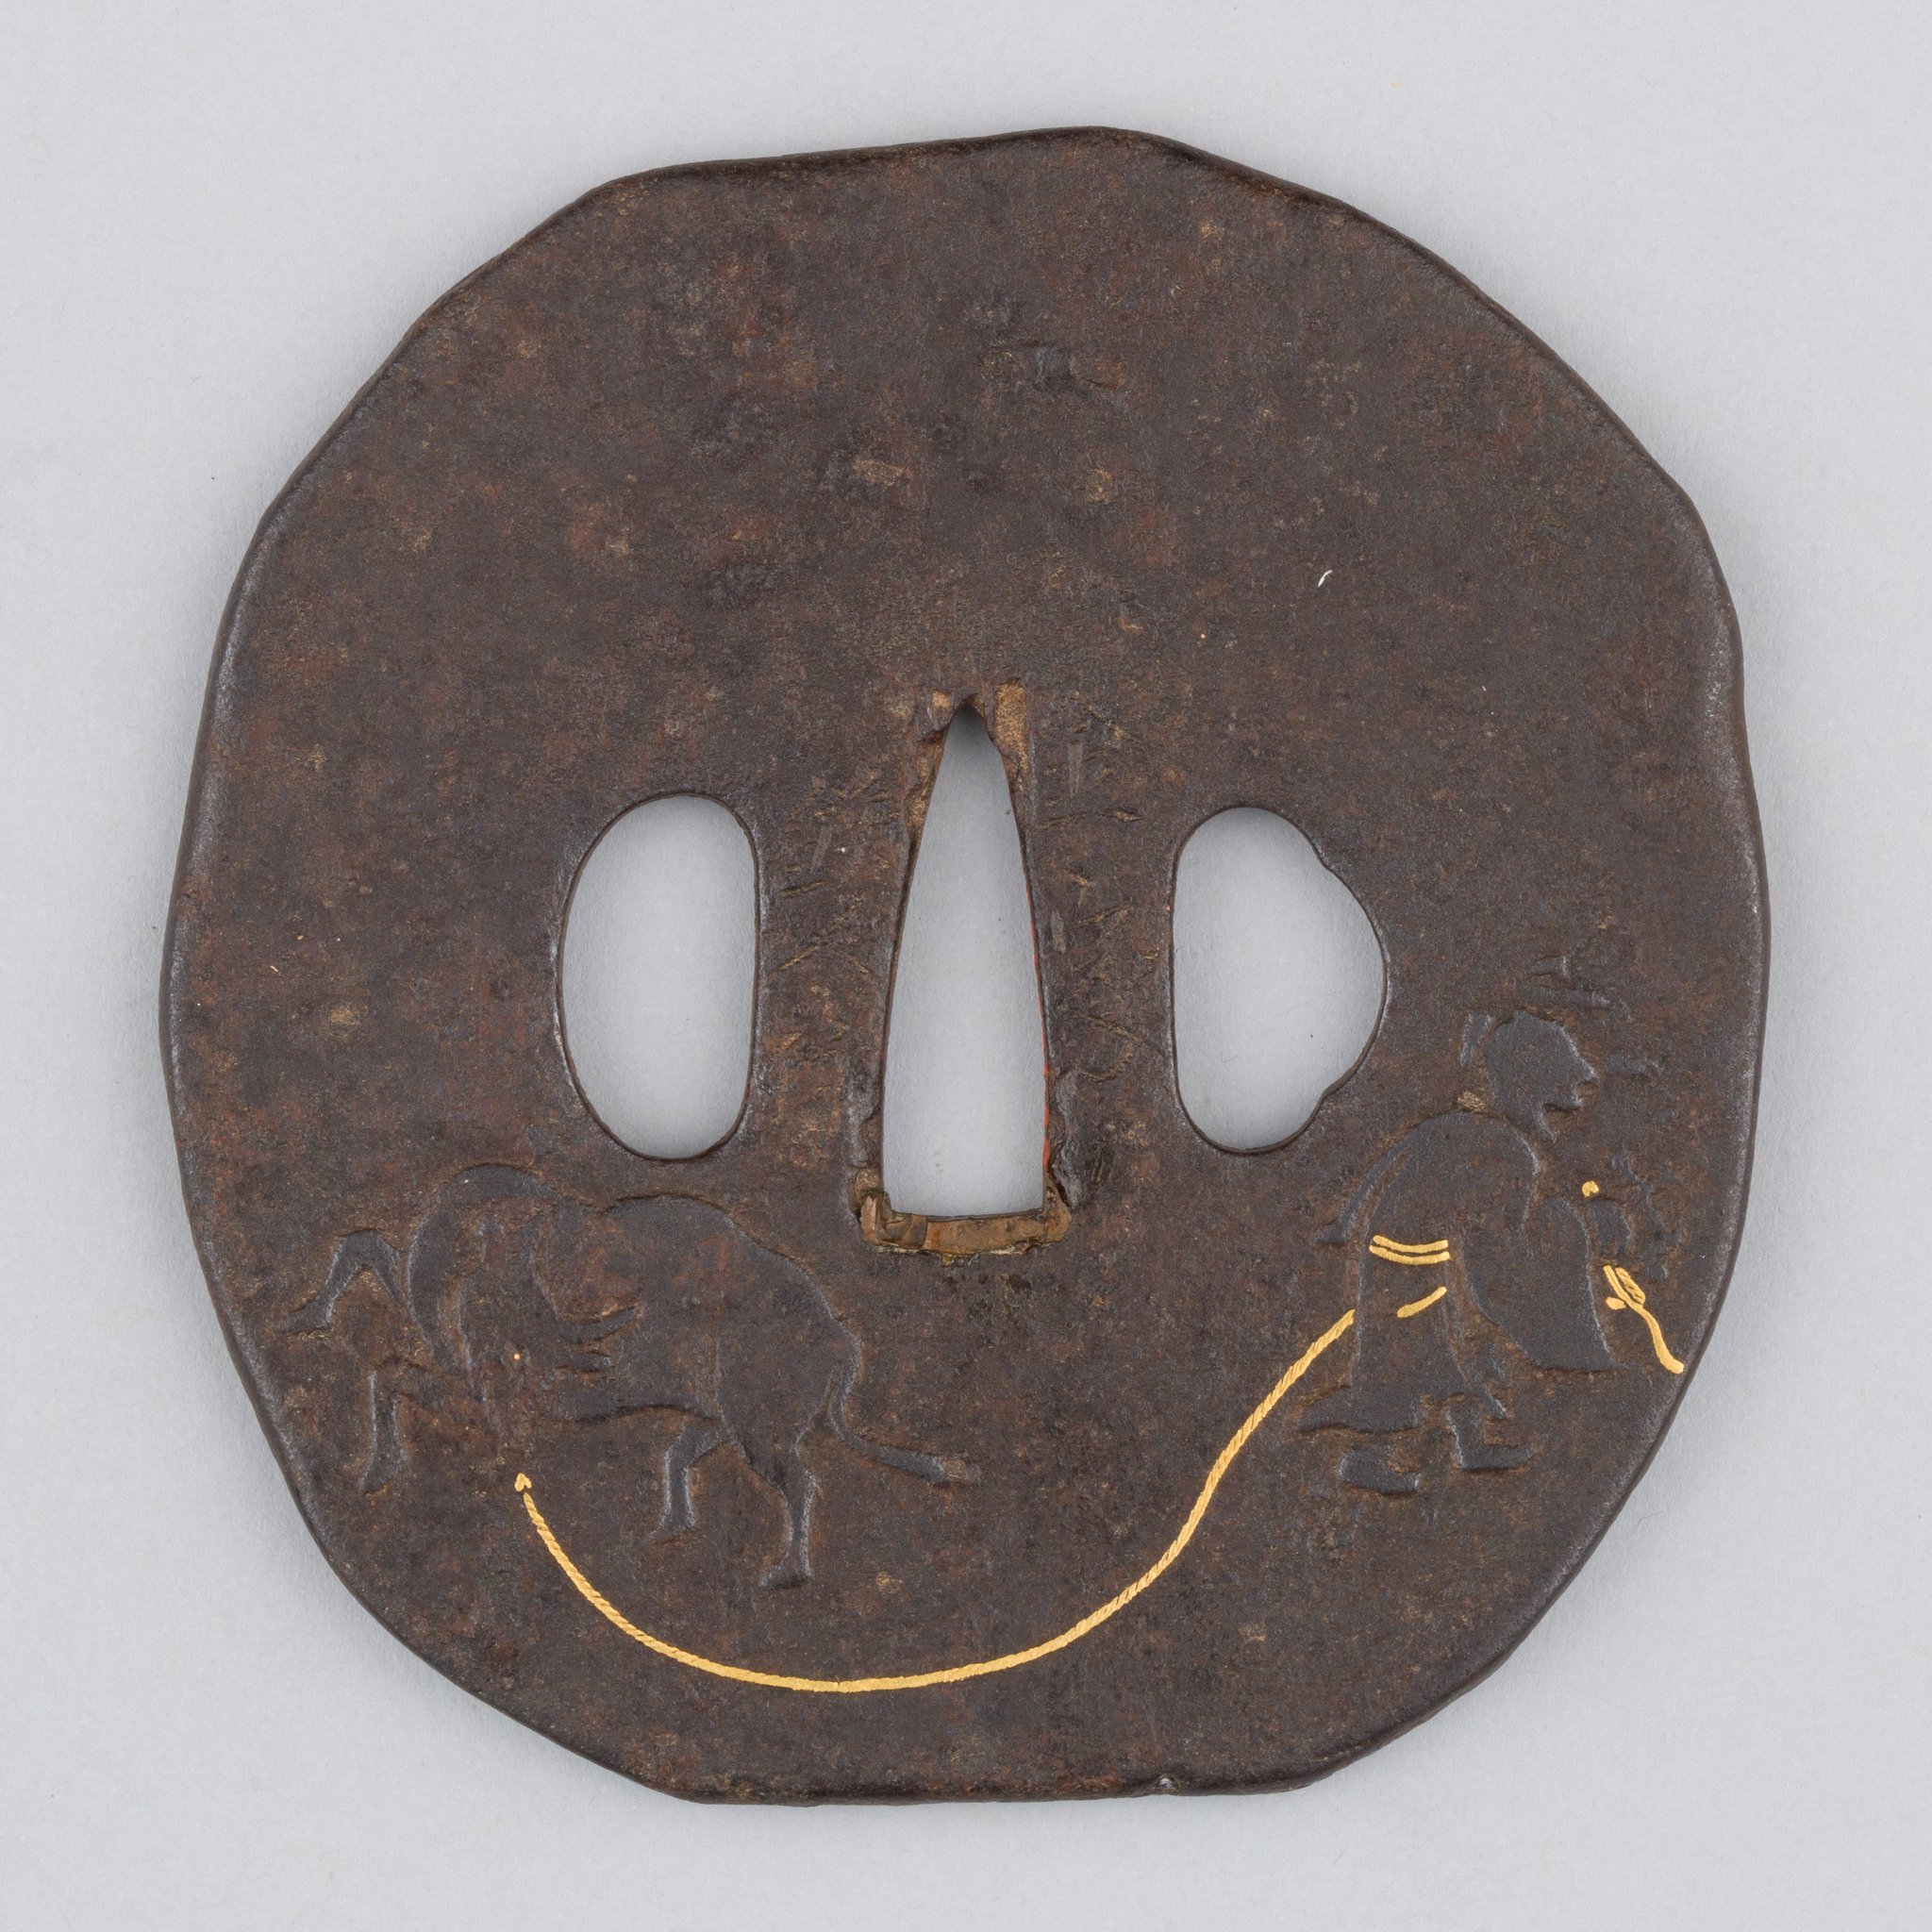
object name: sword guard tsuba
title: Sword Guard (Tsuba)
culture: japanese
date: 1567-1600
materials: copper, gold, iron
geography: japan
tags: human figures,bulls